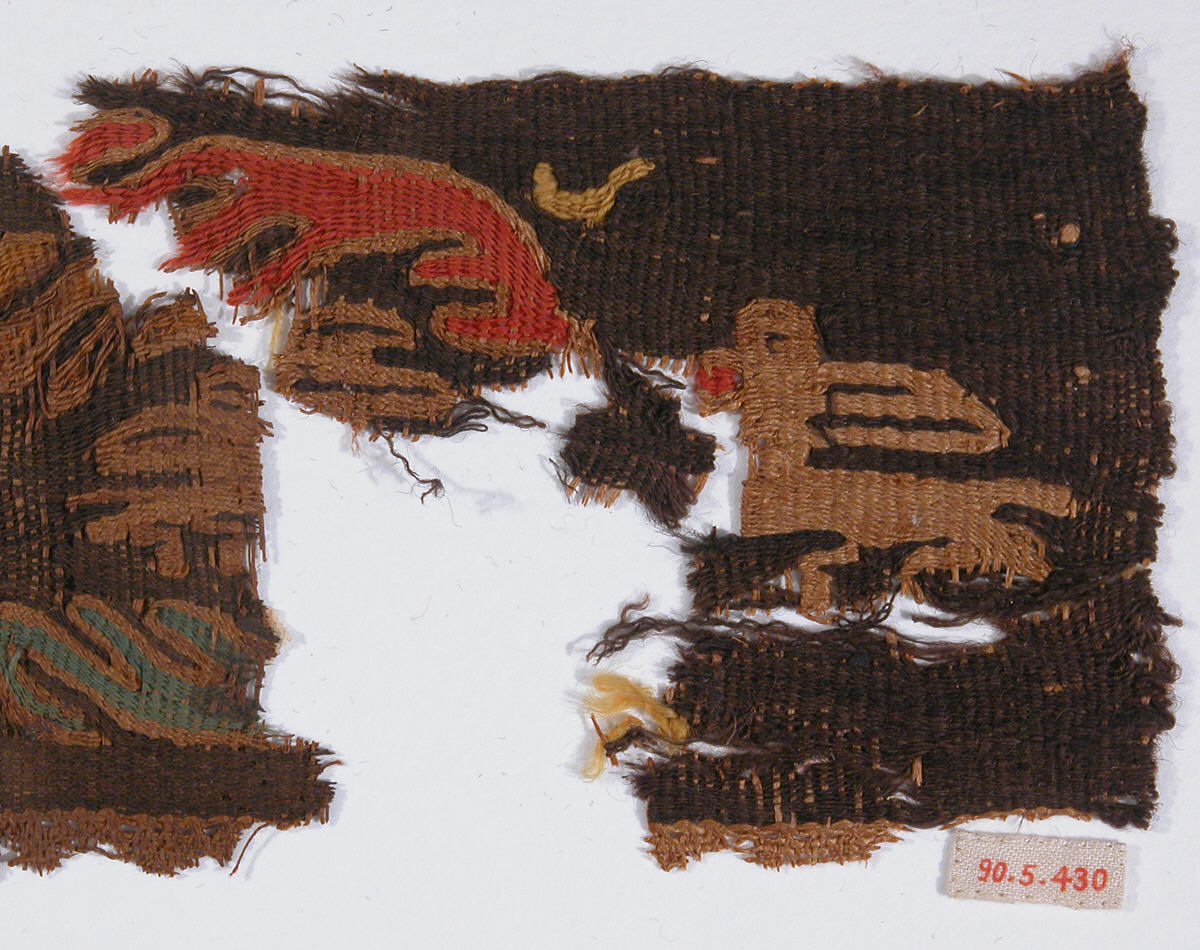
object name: textile fragment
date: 401-500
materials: linen, wool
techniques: weave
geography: egypt